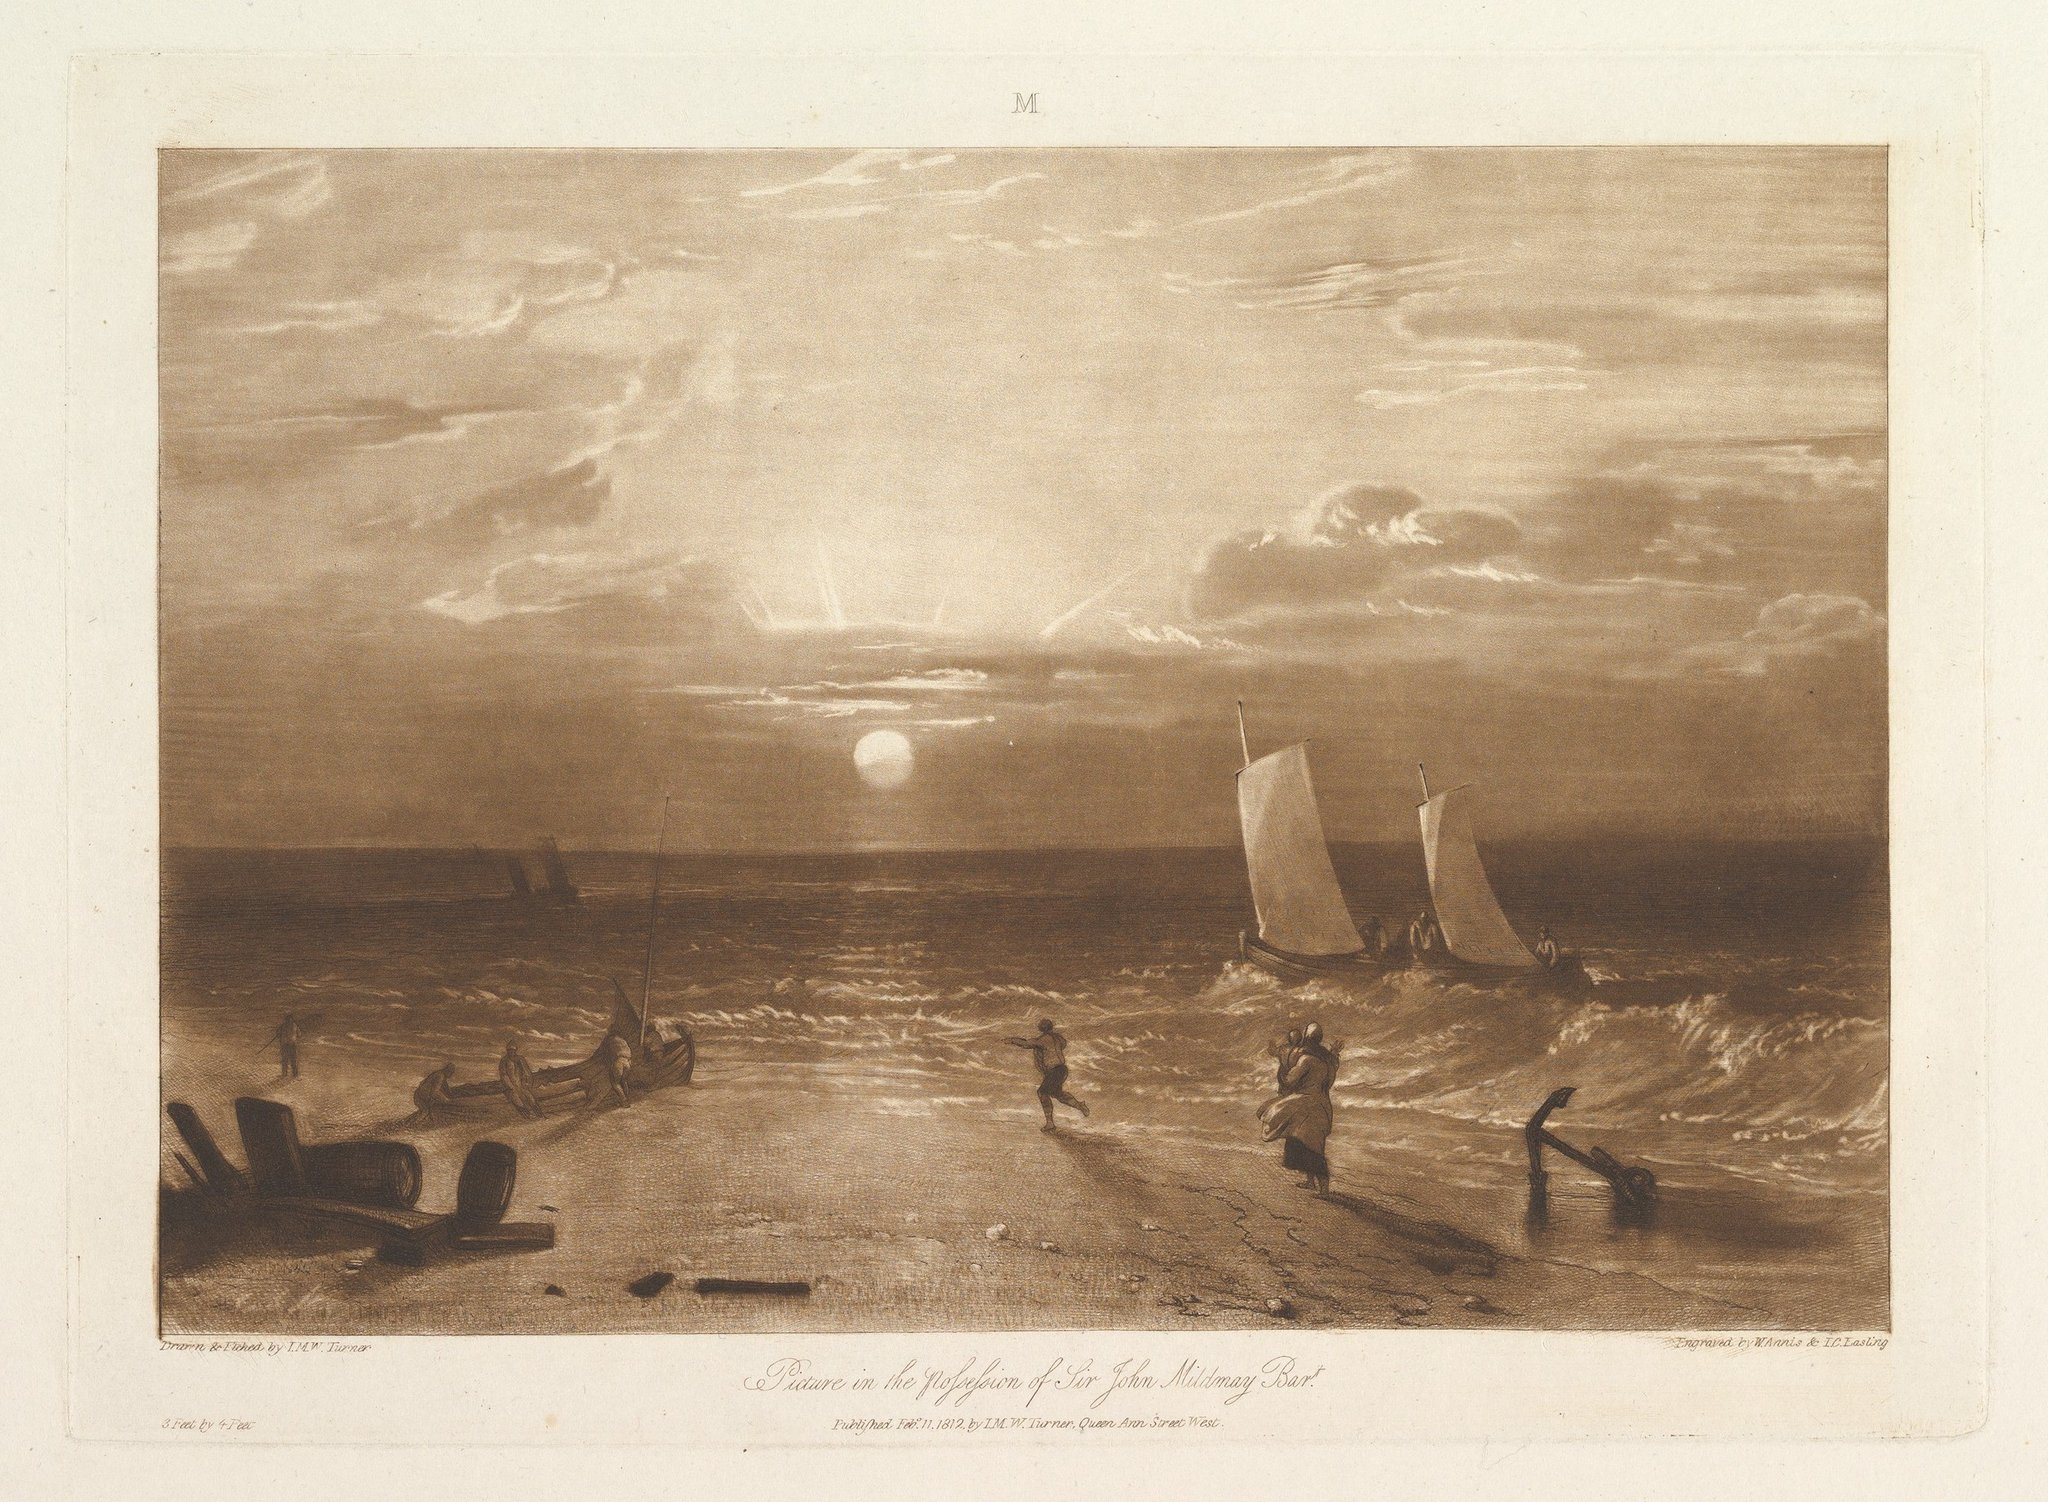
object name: print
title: The Mildmay Sea-Piece, part ViII, plate 40 from "Liber Studiorum"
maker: joseph mallord william turner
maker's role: artist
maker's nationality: british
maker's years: 1775-1851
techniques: etching, mezzotint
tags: beaches,seascapes,boats